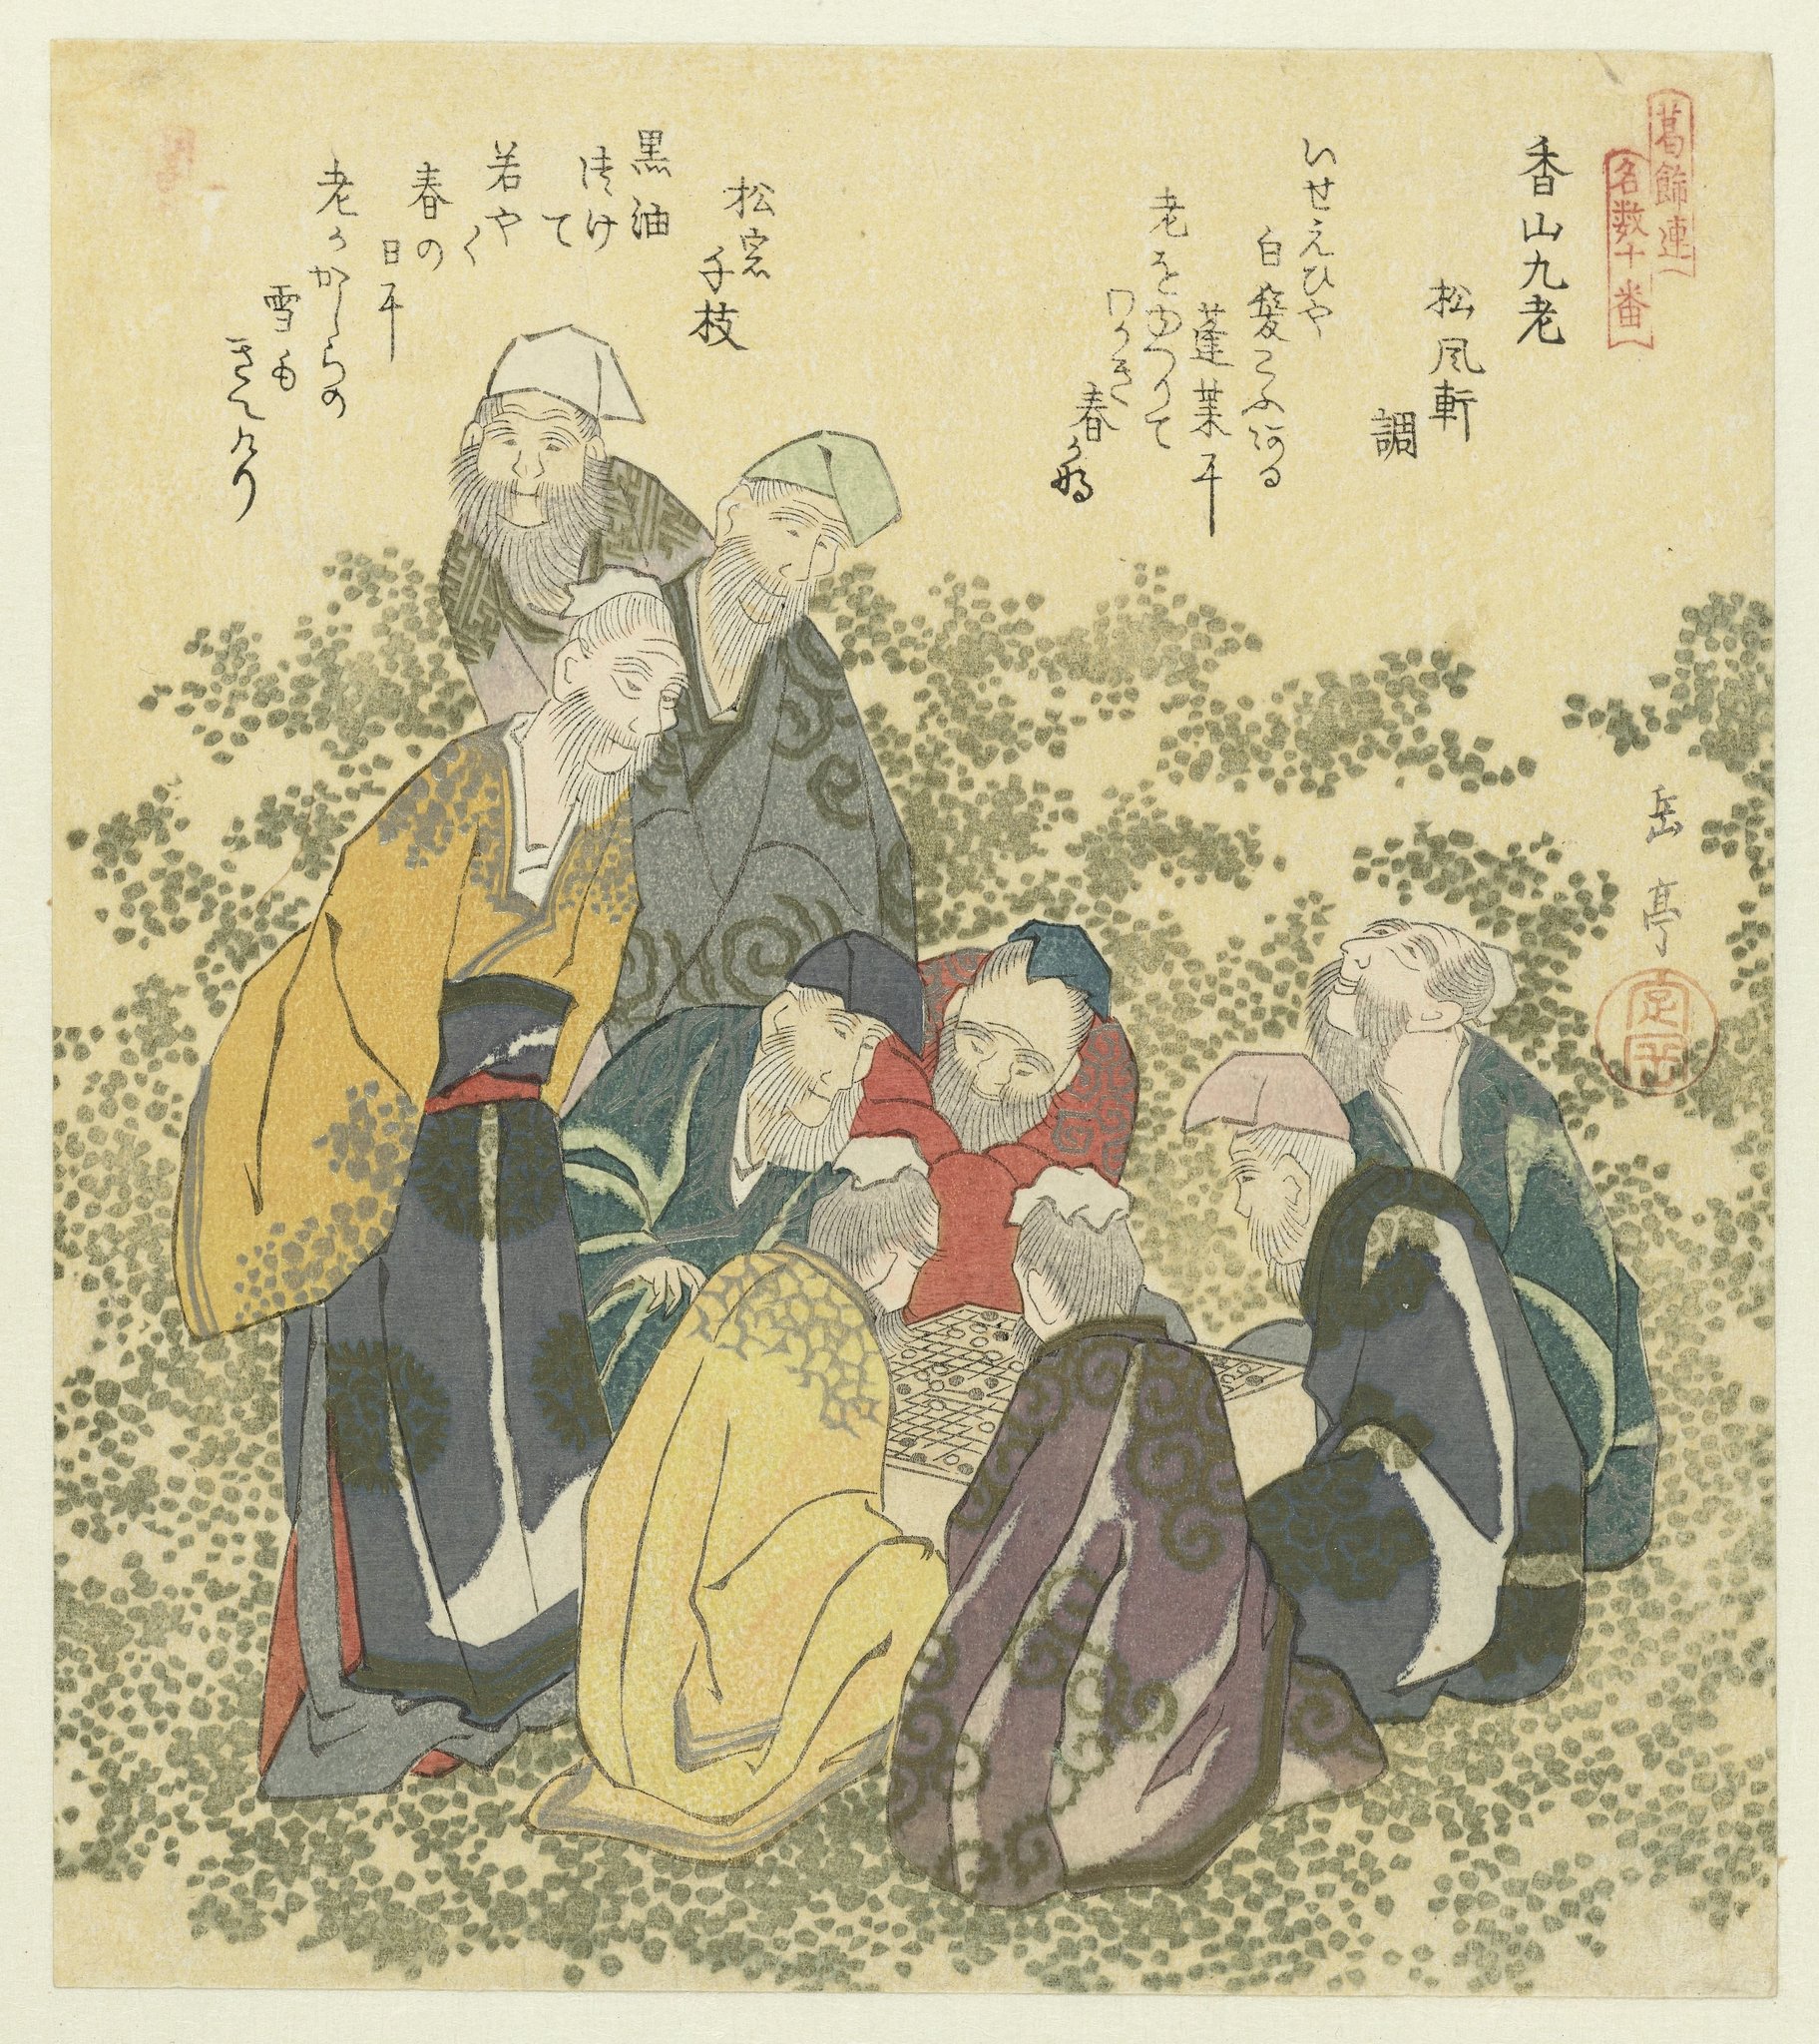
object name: surimono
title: Katsushikaren meisû jûban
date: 1822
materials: paper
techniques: blind stamped, woodcut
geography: japan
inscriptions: collector's mark, verso, stamped: Lugt 2228, collector's mark, passe-partout, bottom left, printed: JABdH with a rooster.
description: Een surimono is een luxe uitgevoerde prent waarop beeld met één of meerdere gedichten gecombineerd is. Bij het drukken van een surimono werd vaak gebruik gemaakt van dikker papier, blinddruk en metaal pigmenten, zoals koper- en zilverpoeder. De prenten werden vaak in opdracht van dichters gemaakt en als exclusief geschenk aan vrienden en relaties gegeven.